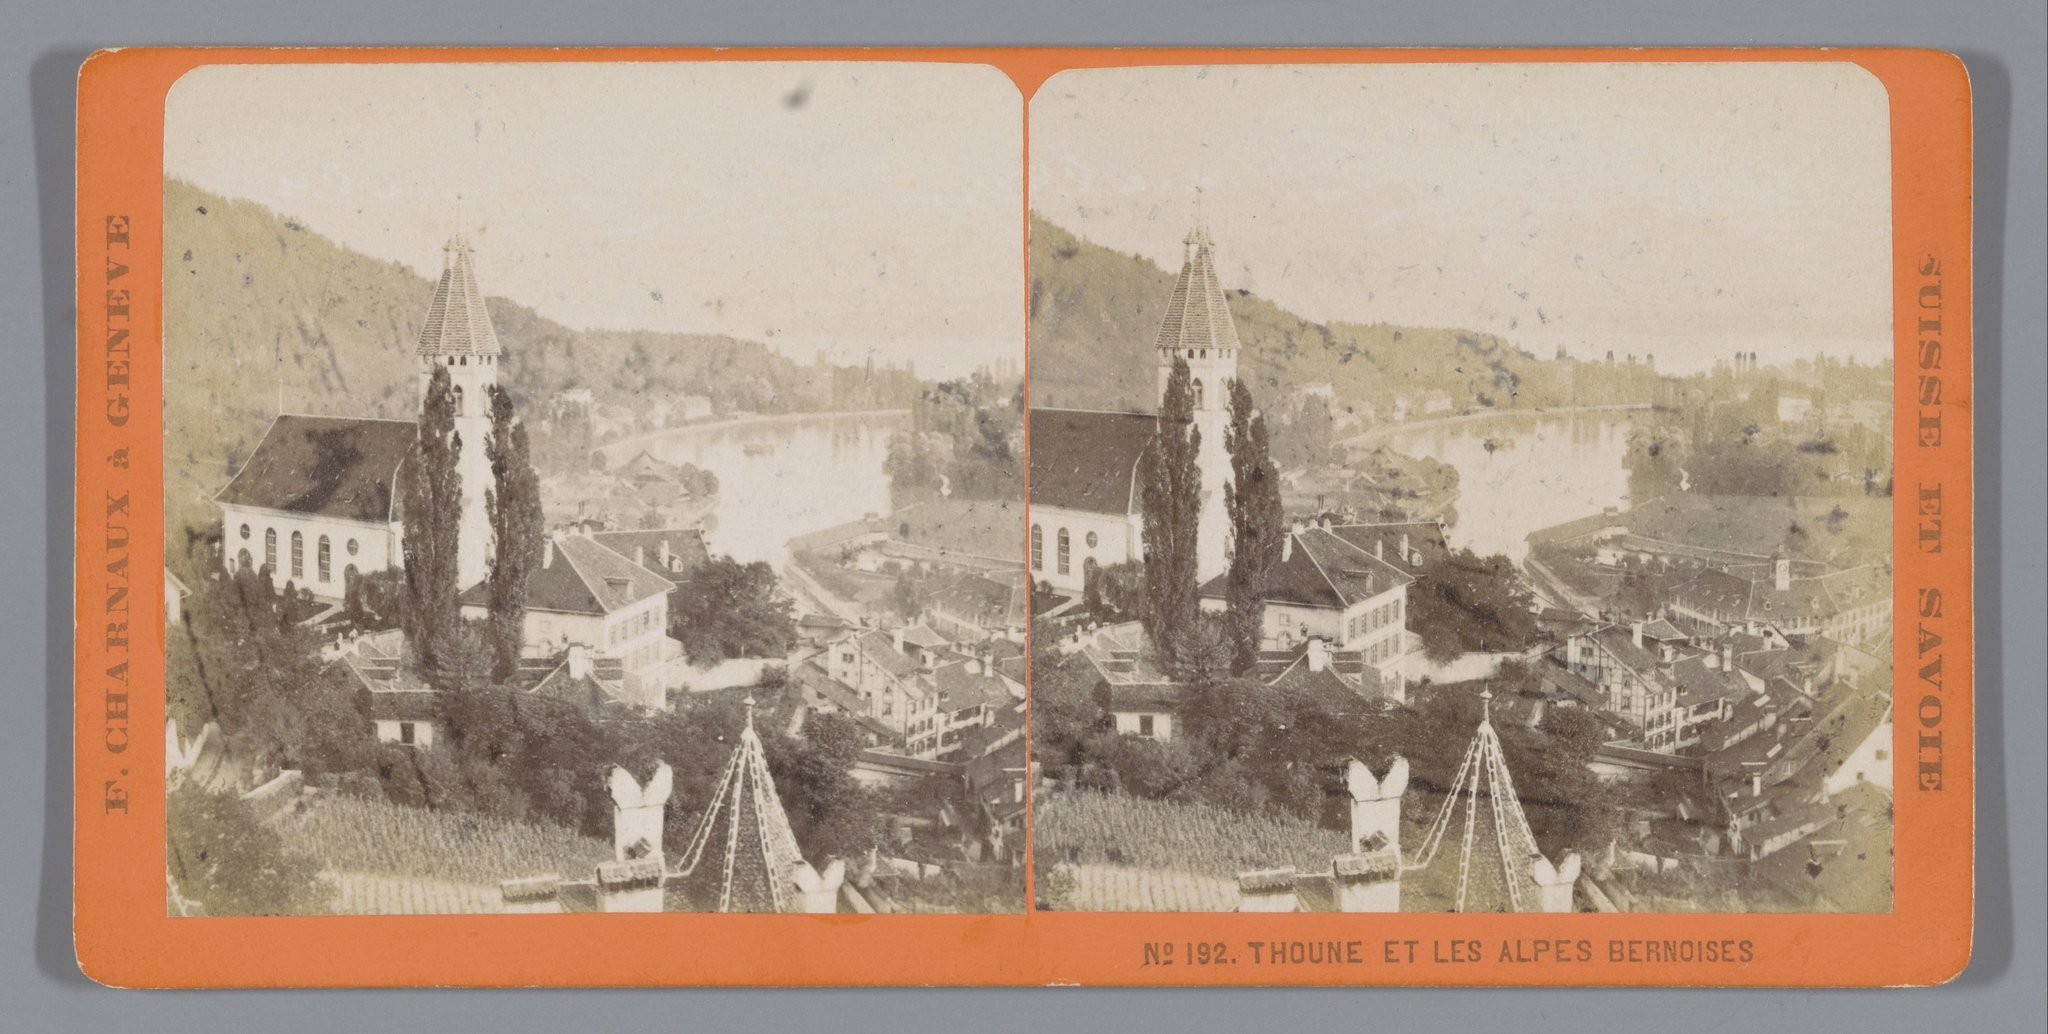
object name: stereograph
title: Thoune et les Alpes Bernoises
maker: florentin charnaux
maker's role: publisher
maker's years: 1819-1883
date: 1873-1880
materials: cardboard, photographic support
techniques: albumen print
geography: thun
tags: city-view in general; 'veduta'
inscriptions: inscription: ‘1875 No 9. Aug 1885. Aug 1896. Za 18 Sept. Aug 1893.’, number: ‘No 192.’, annotation: ‘Paris 1870 Lyon 1872 Vienne 1873 Maison des Trois Rois - F. Charnaux Genève.’, inscription: ‘Suisse et Savoie’